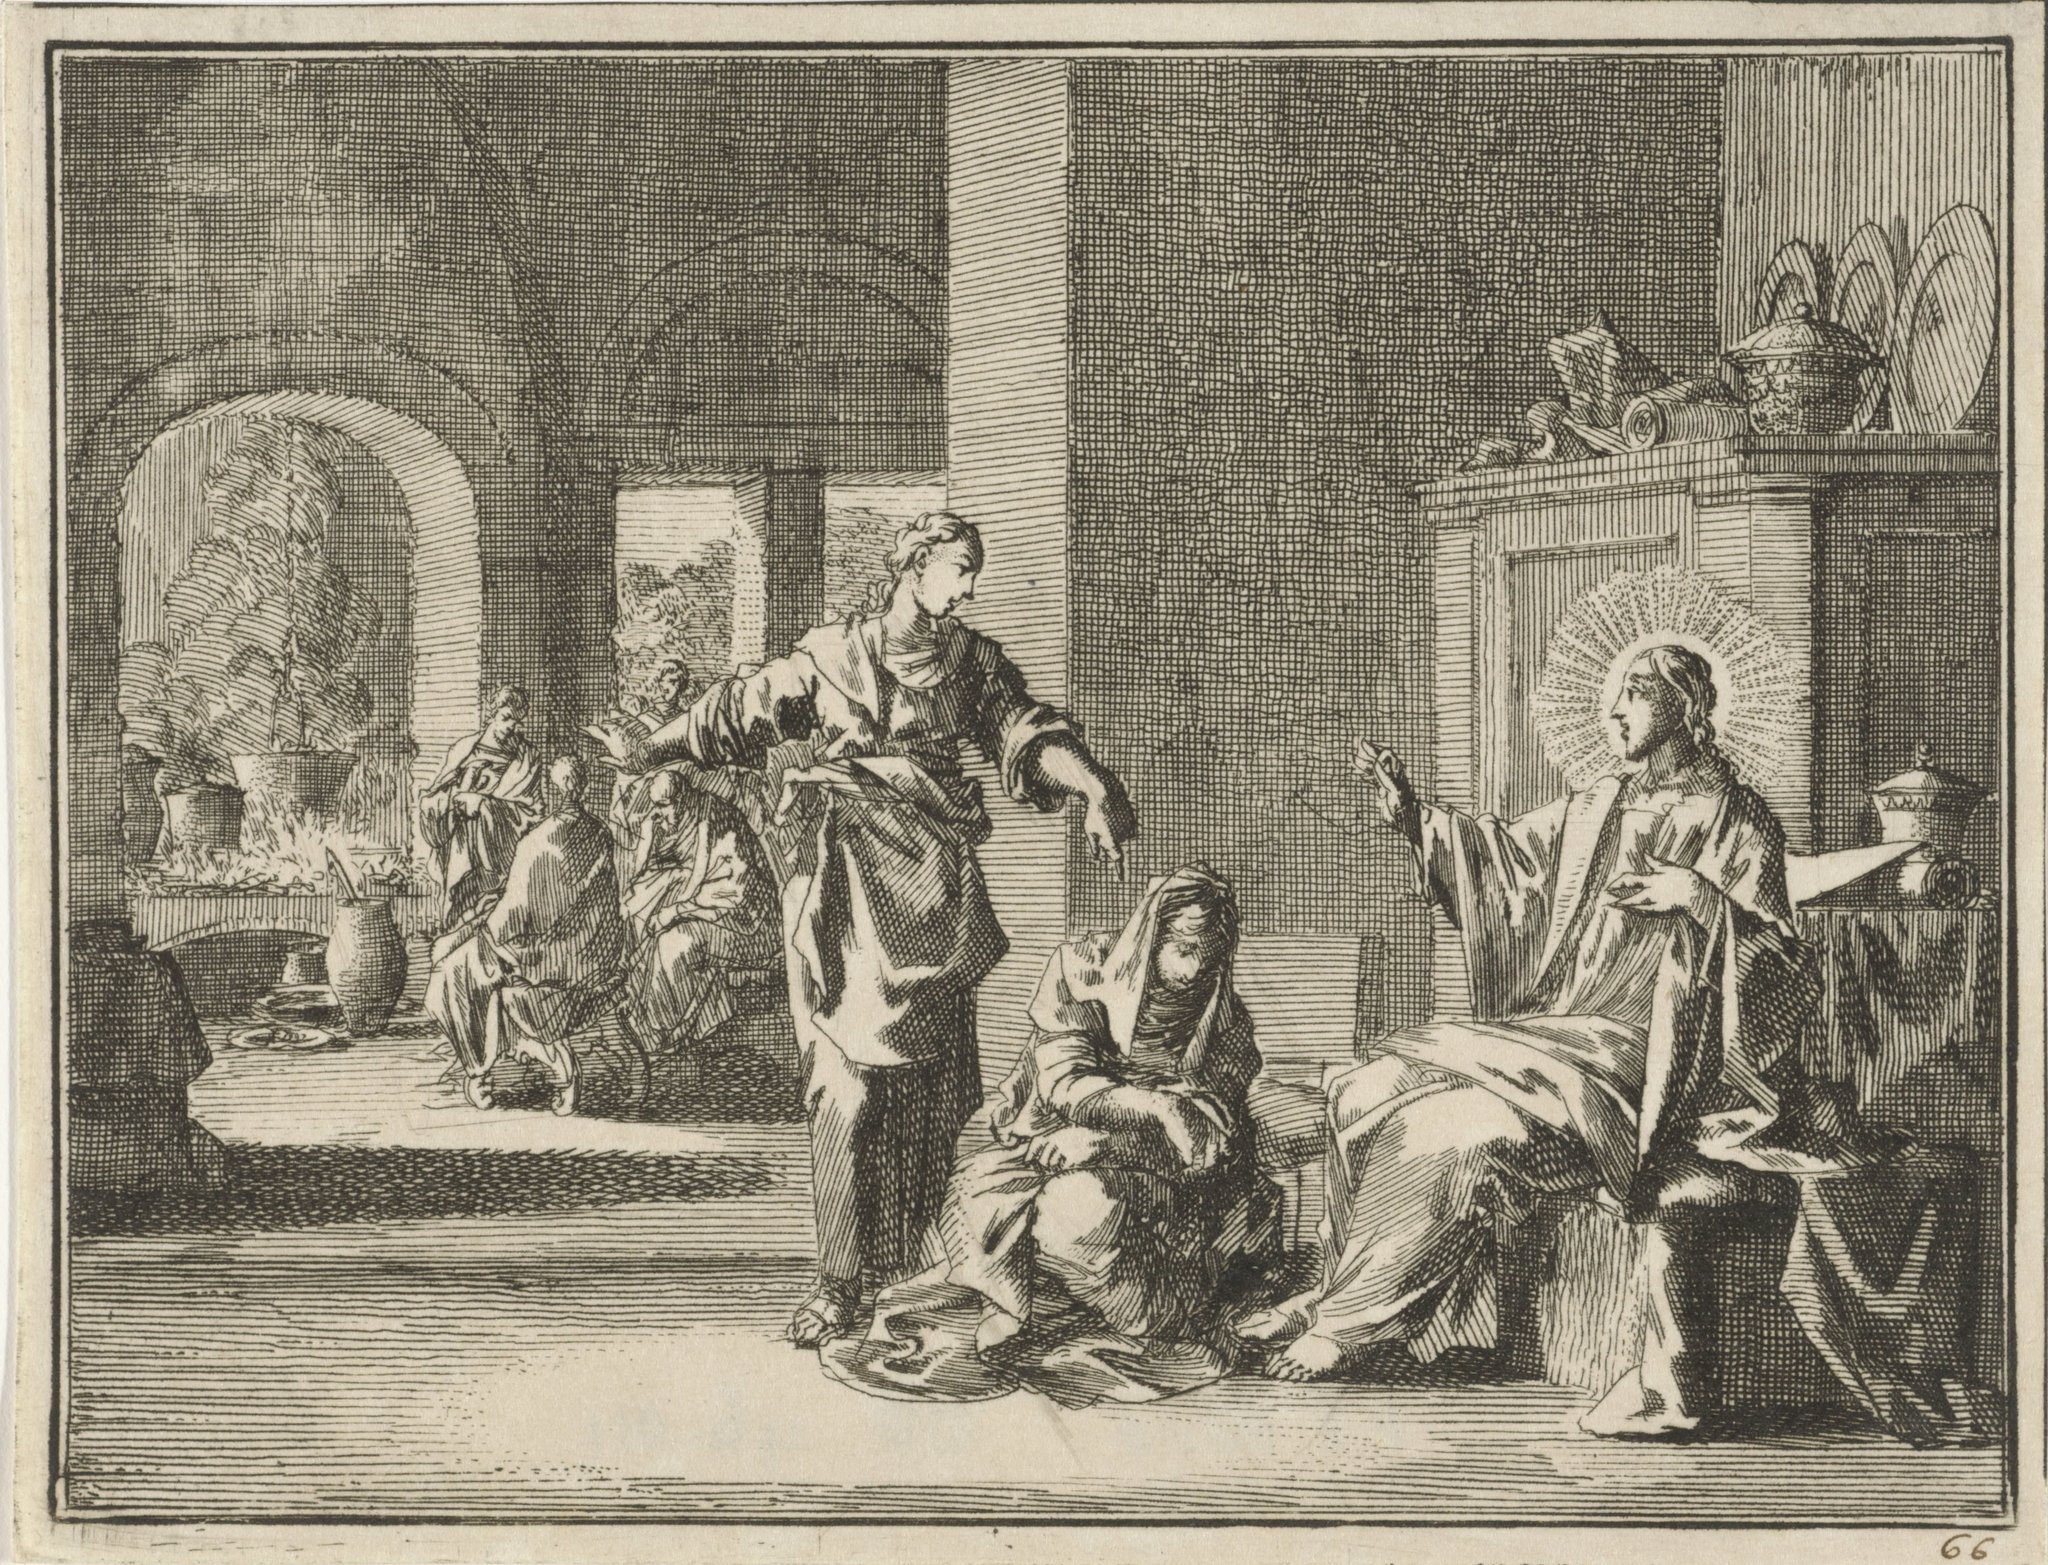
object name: print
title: Christus in het huis van Marta en Maria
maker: jan luyken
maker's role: draughtsman, print maker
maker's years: 1649-1712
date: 1712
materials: paper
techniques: etching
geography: amsterdam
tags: christ in the house of martha and mary (luke 10:38-42)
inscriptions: collector's mark: Lugt 2228, number: ‘66’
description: Proefdruk van illustratie uit: Luyken, Jan. De schriftuurlyke geschiedenissen en gelykenissen van het Oude en Nieuwe Verbond, 2 delen. Amsterdam: Wed. Pieter Arentsz II en Cornelis van der Sys, 1712, dl. II.